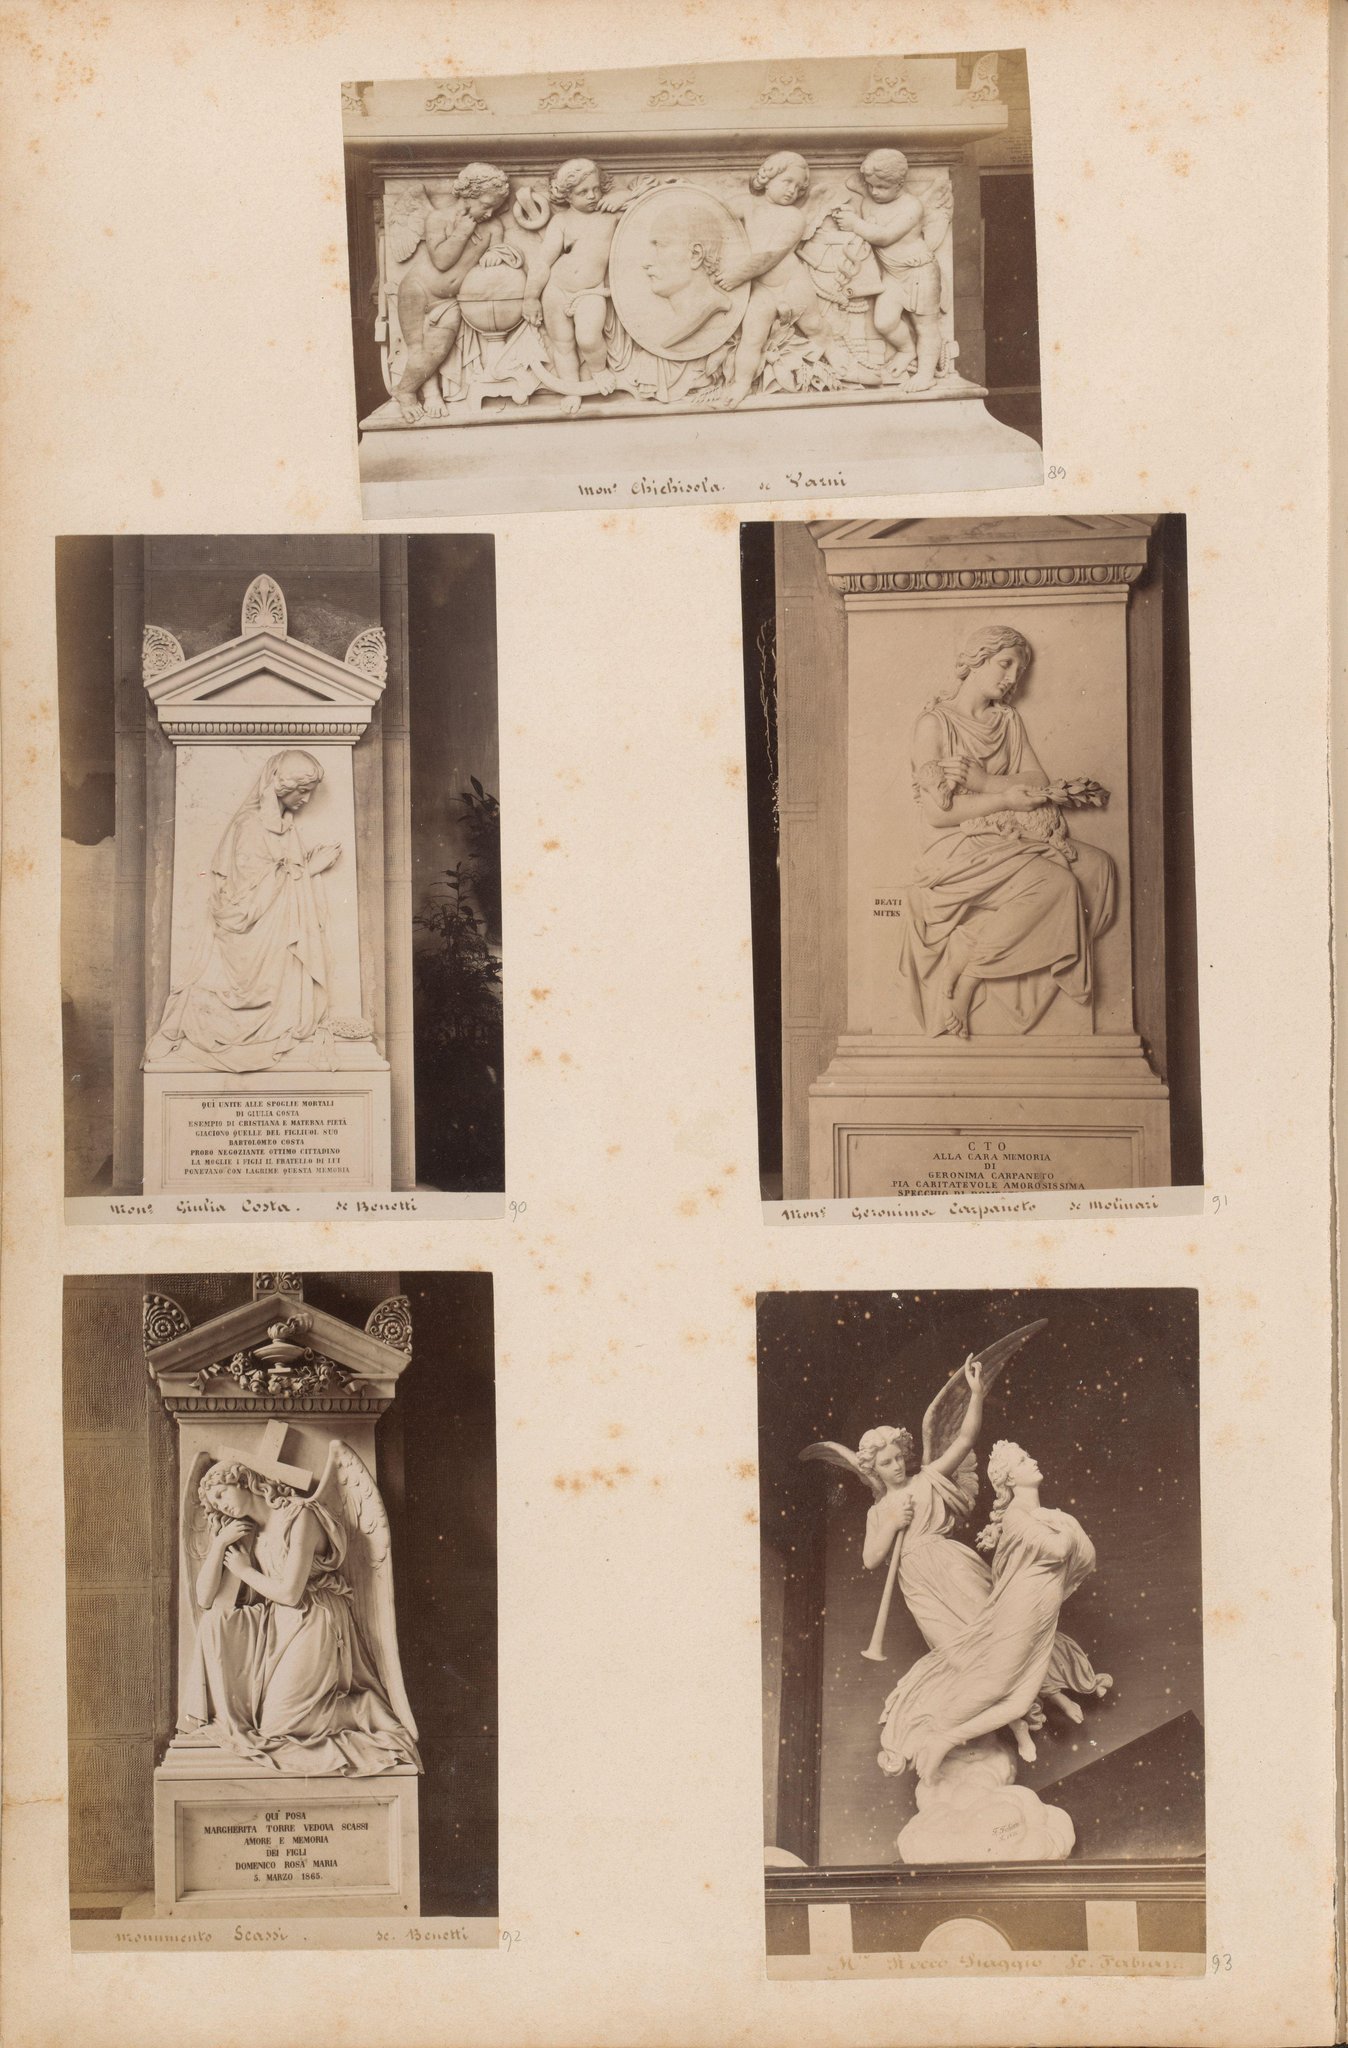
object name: photograph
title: Mon.o Scassi sc. Benetti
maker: Anonymous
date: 1870-1880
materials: paper, photographic support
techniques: albumen print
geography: genoa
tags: piece of sculpture, reproduction of a piece of sculpture (+ sculpture), grave, tomb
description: Onderdeel van Fotoalbum van Robert Daniel Crommelin (1841-1907).